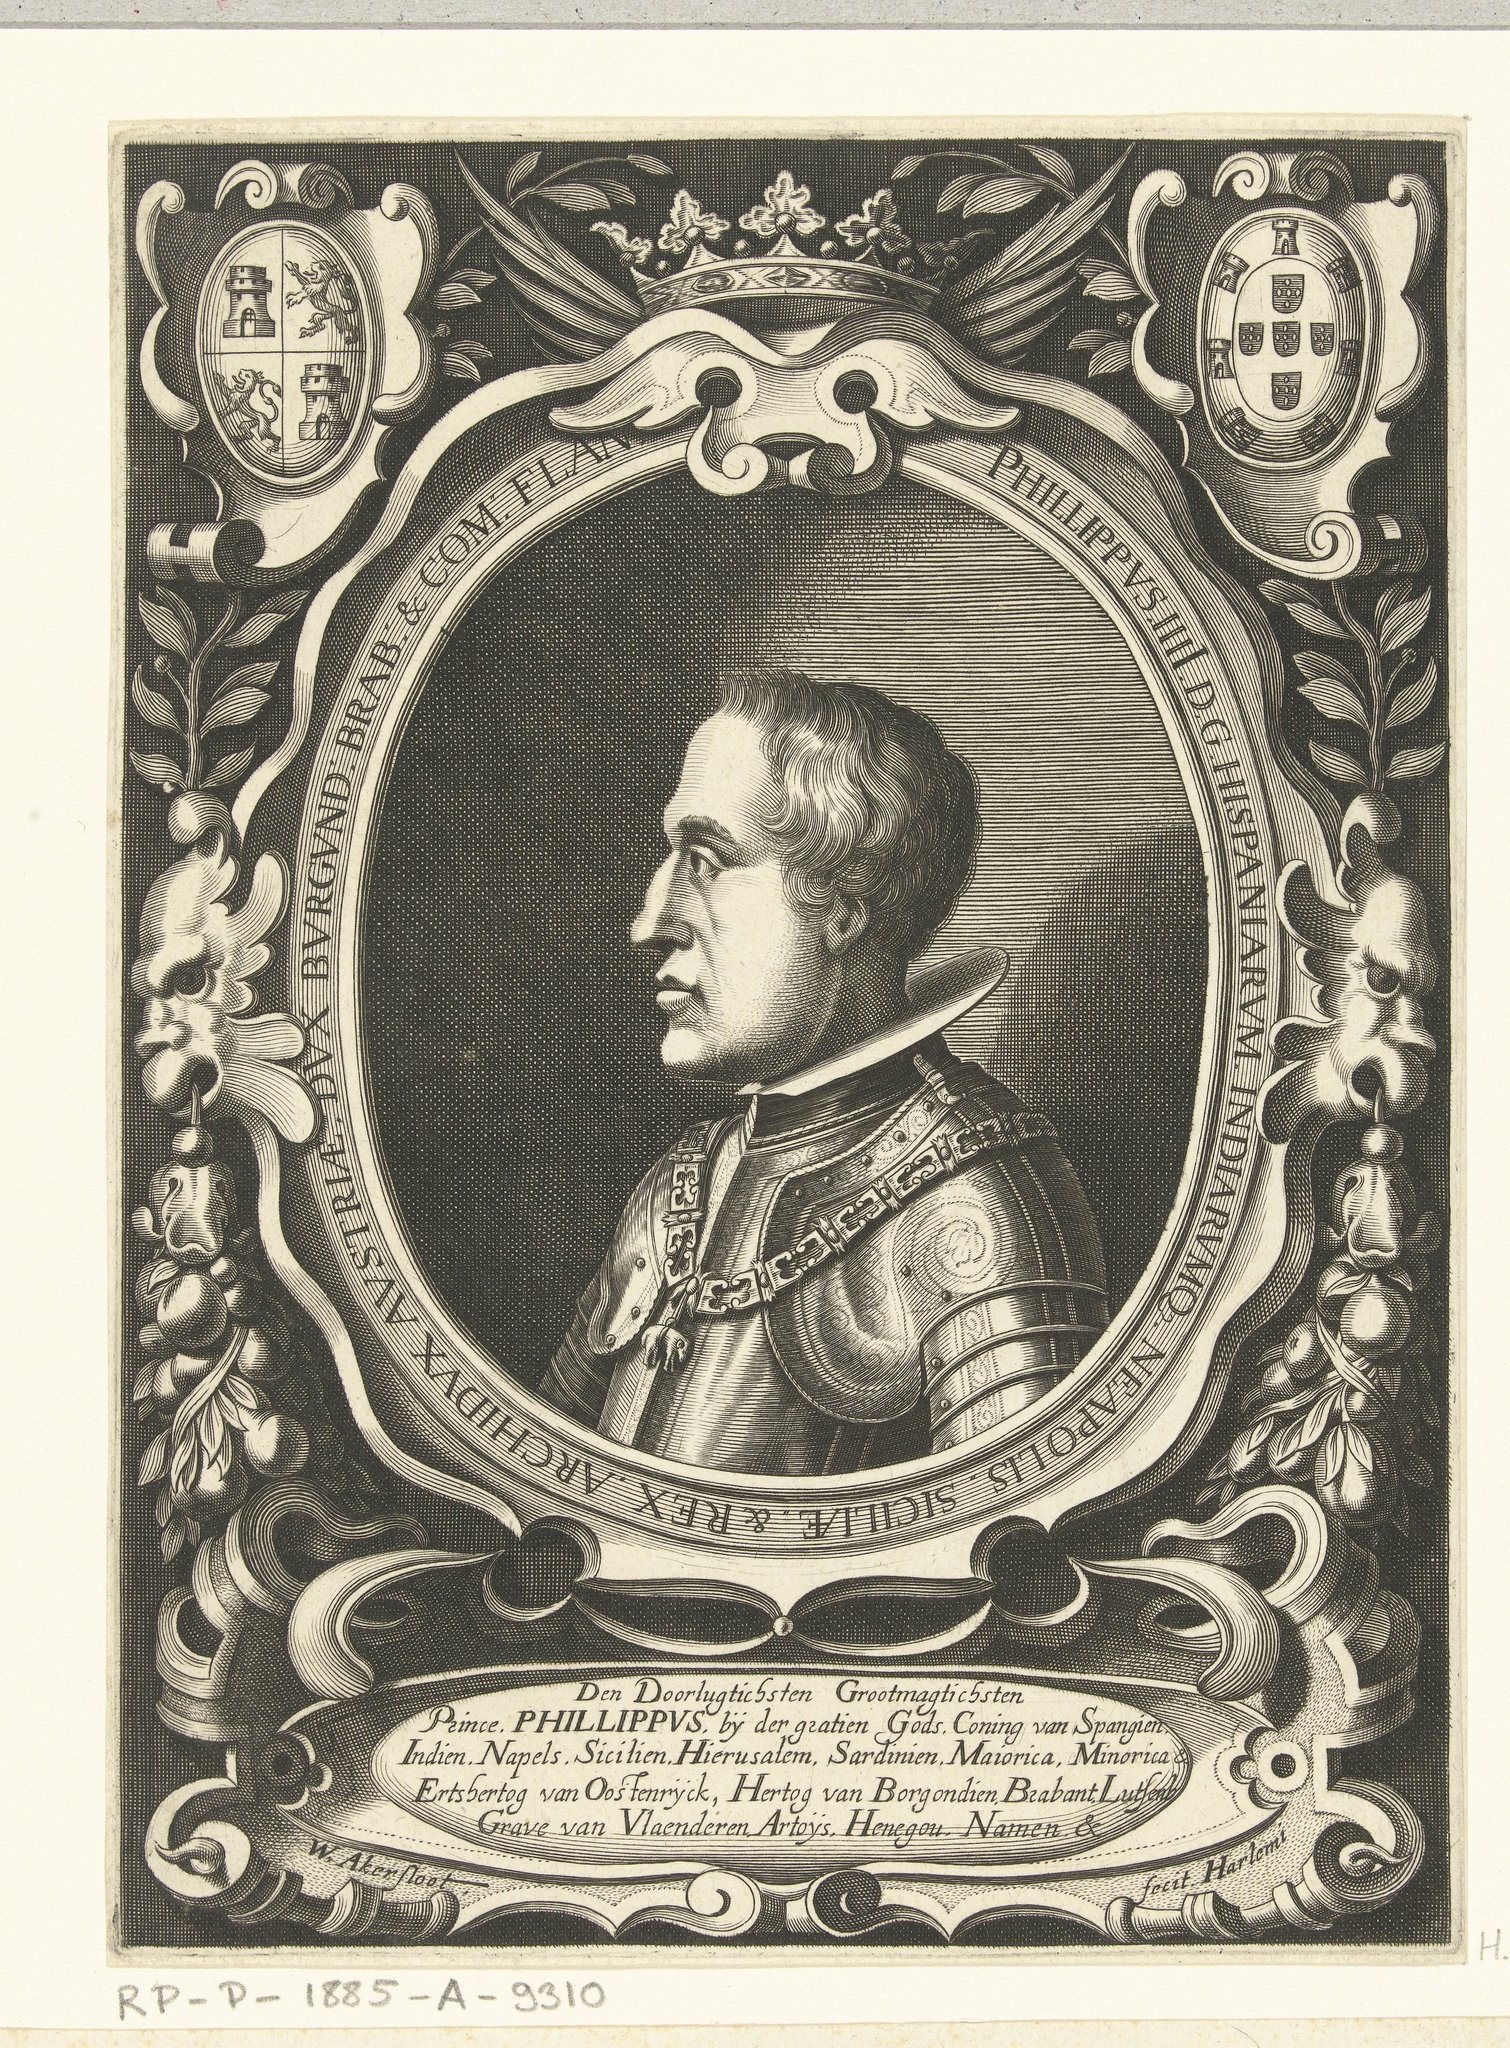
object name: print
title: Portret van Filips IV koning van Spanje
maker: willem outgertsz. akersloot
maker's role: print maker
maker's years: 1600-1651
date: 1610-1633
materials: paper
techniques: engraving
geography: haarlem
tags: filips iv (koning van spanje), historical persons, knighthood order of the golden fleece - insignia of a knighthood order, e.g.: badge, chain (with name of order)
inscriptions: collector's mark: Lugt 2228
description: Portret van Filips IV koning van Spanje met wapenrusting en ketting van de Orde van het Gulden Vlies, in ovale ornamentlijst met randschrift. Op de lijst een kroon. Onderschrift in cartouche.